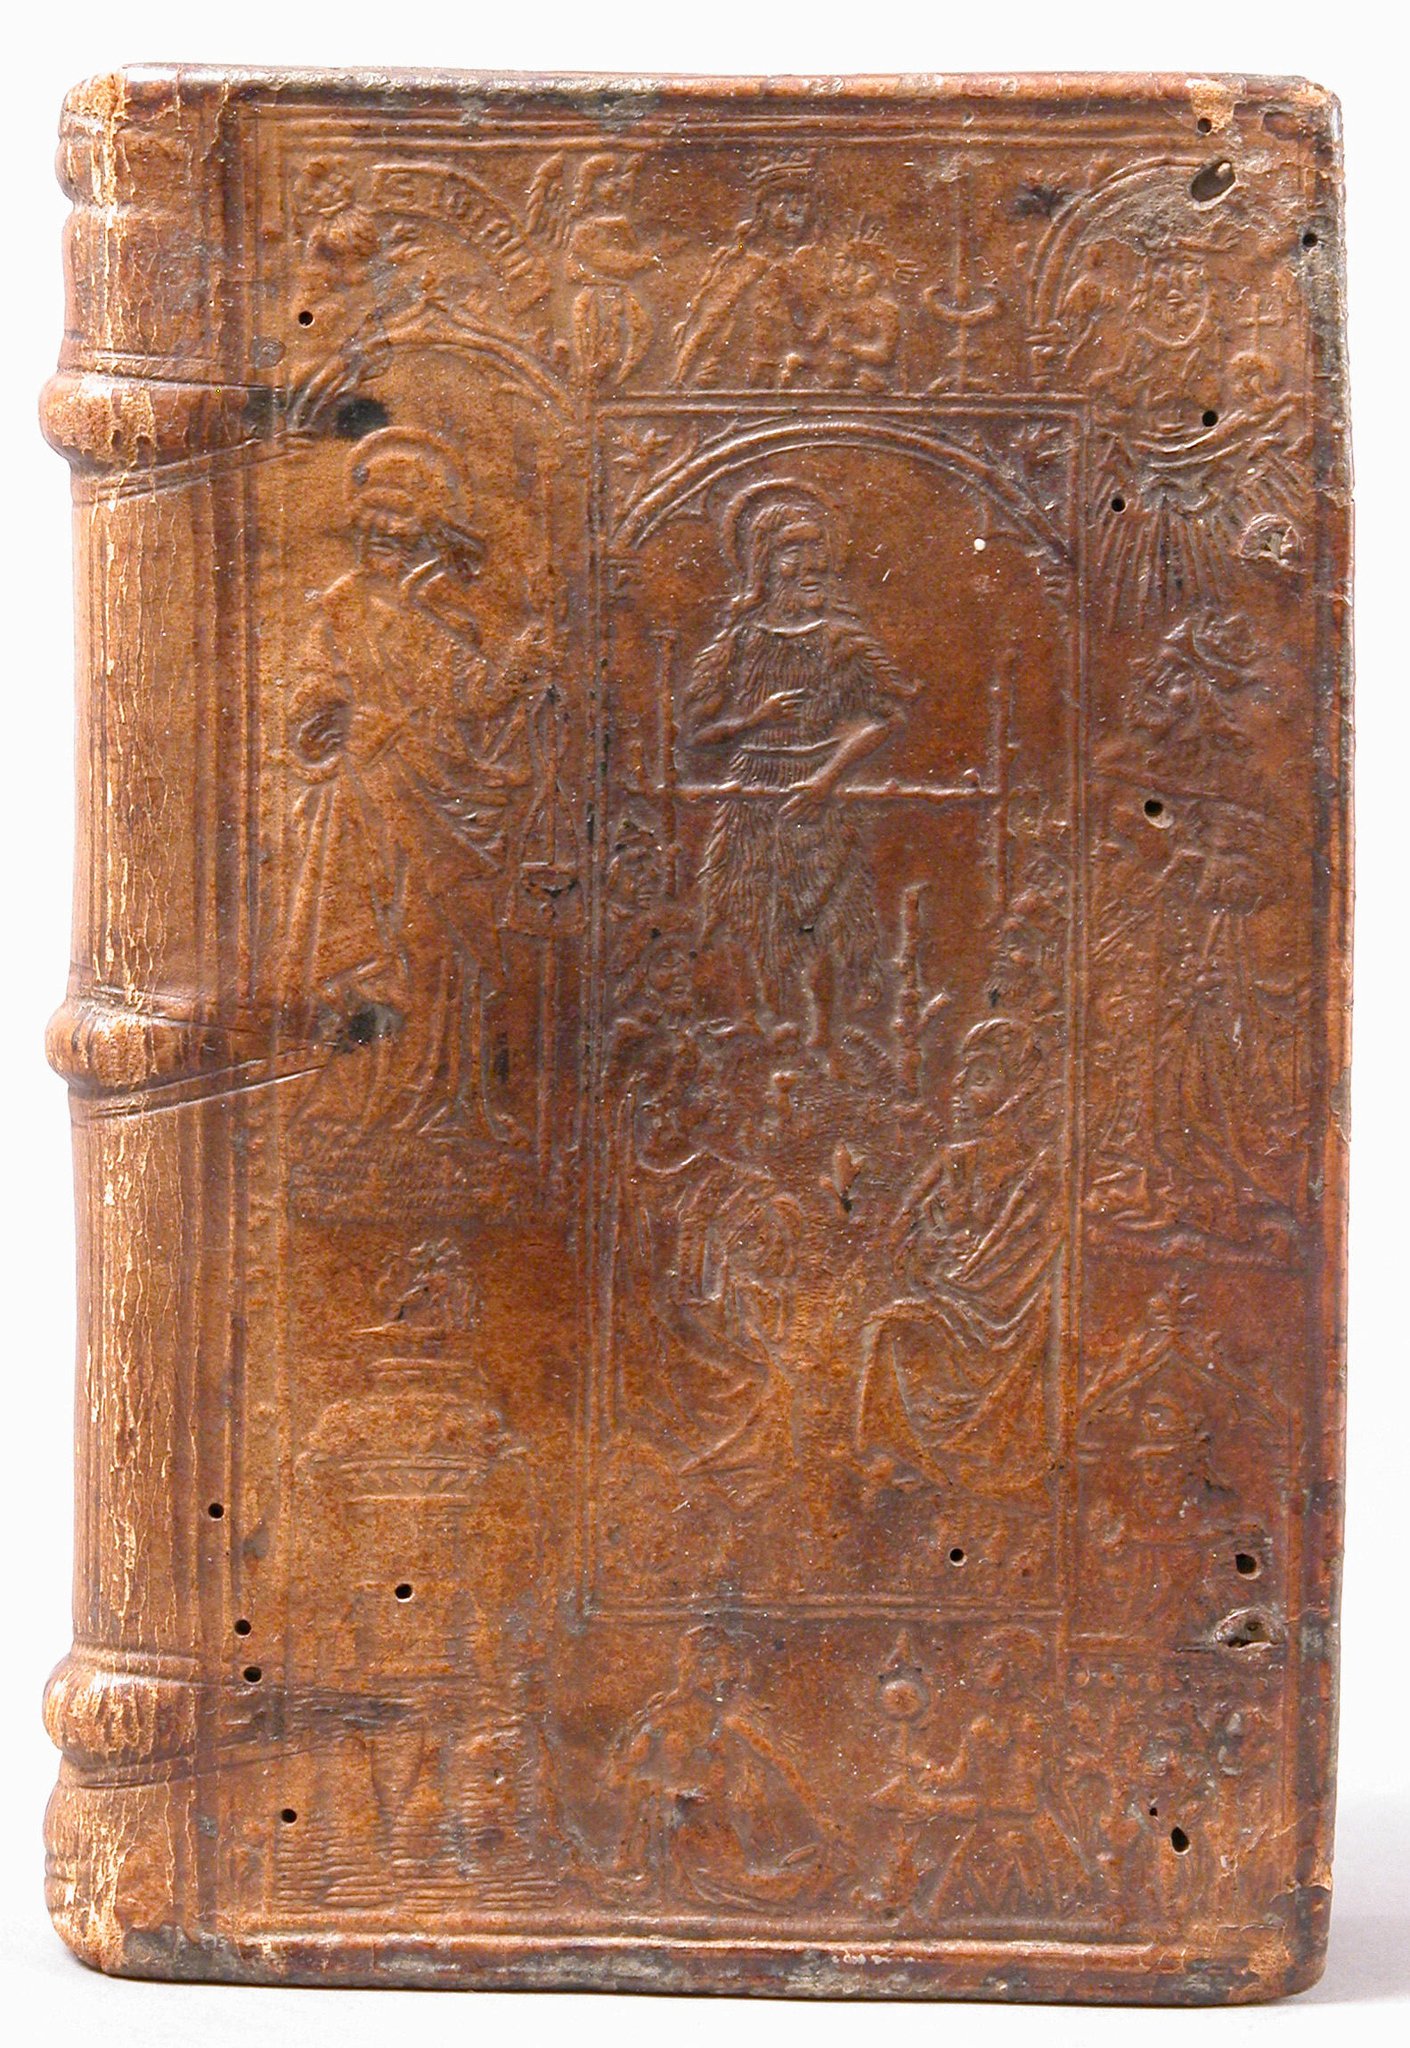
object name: book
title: Printed Book with Silva Nuptialis Bonis Referta Non Modicis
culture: french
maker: johannes nevizanus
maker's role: artist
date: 1521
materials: leather, paper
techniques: bookbinding, printing, tooling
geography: france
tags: human figures